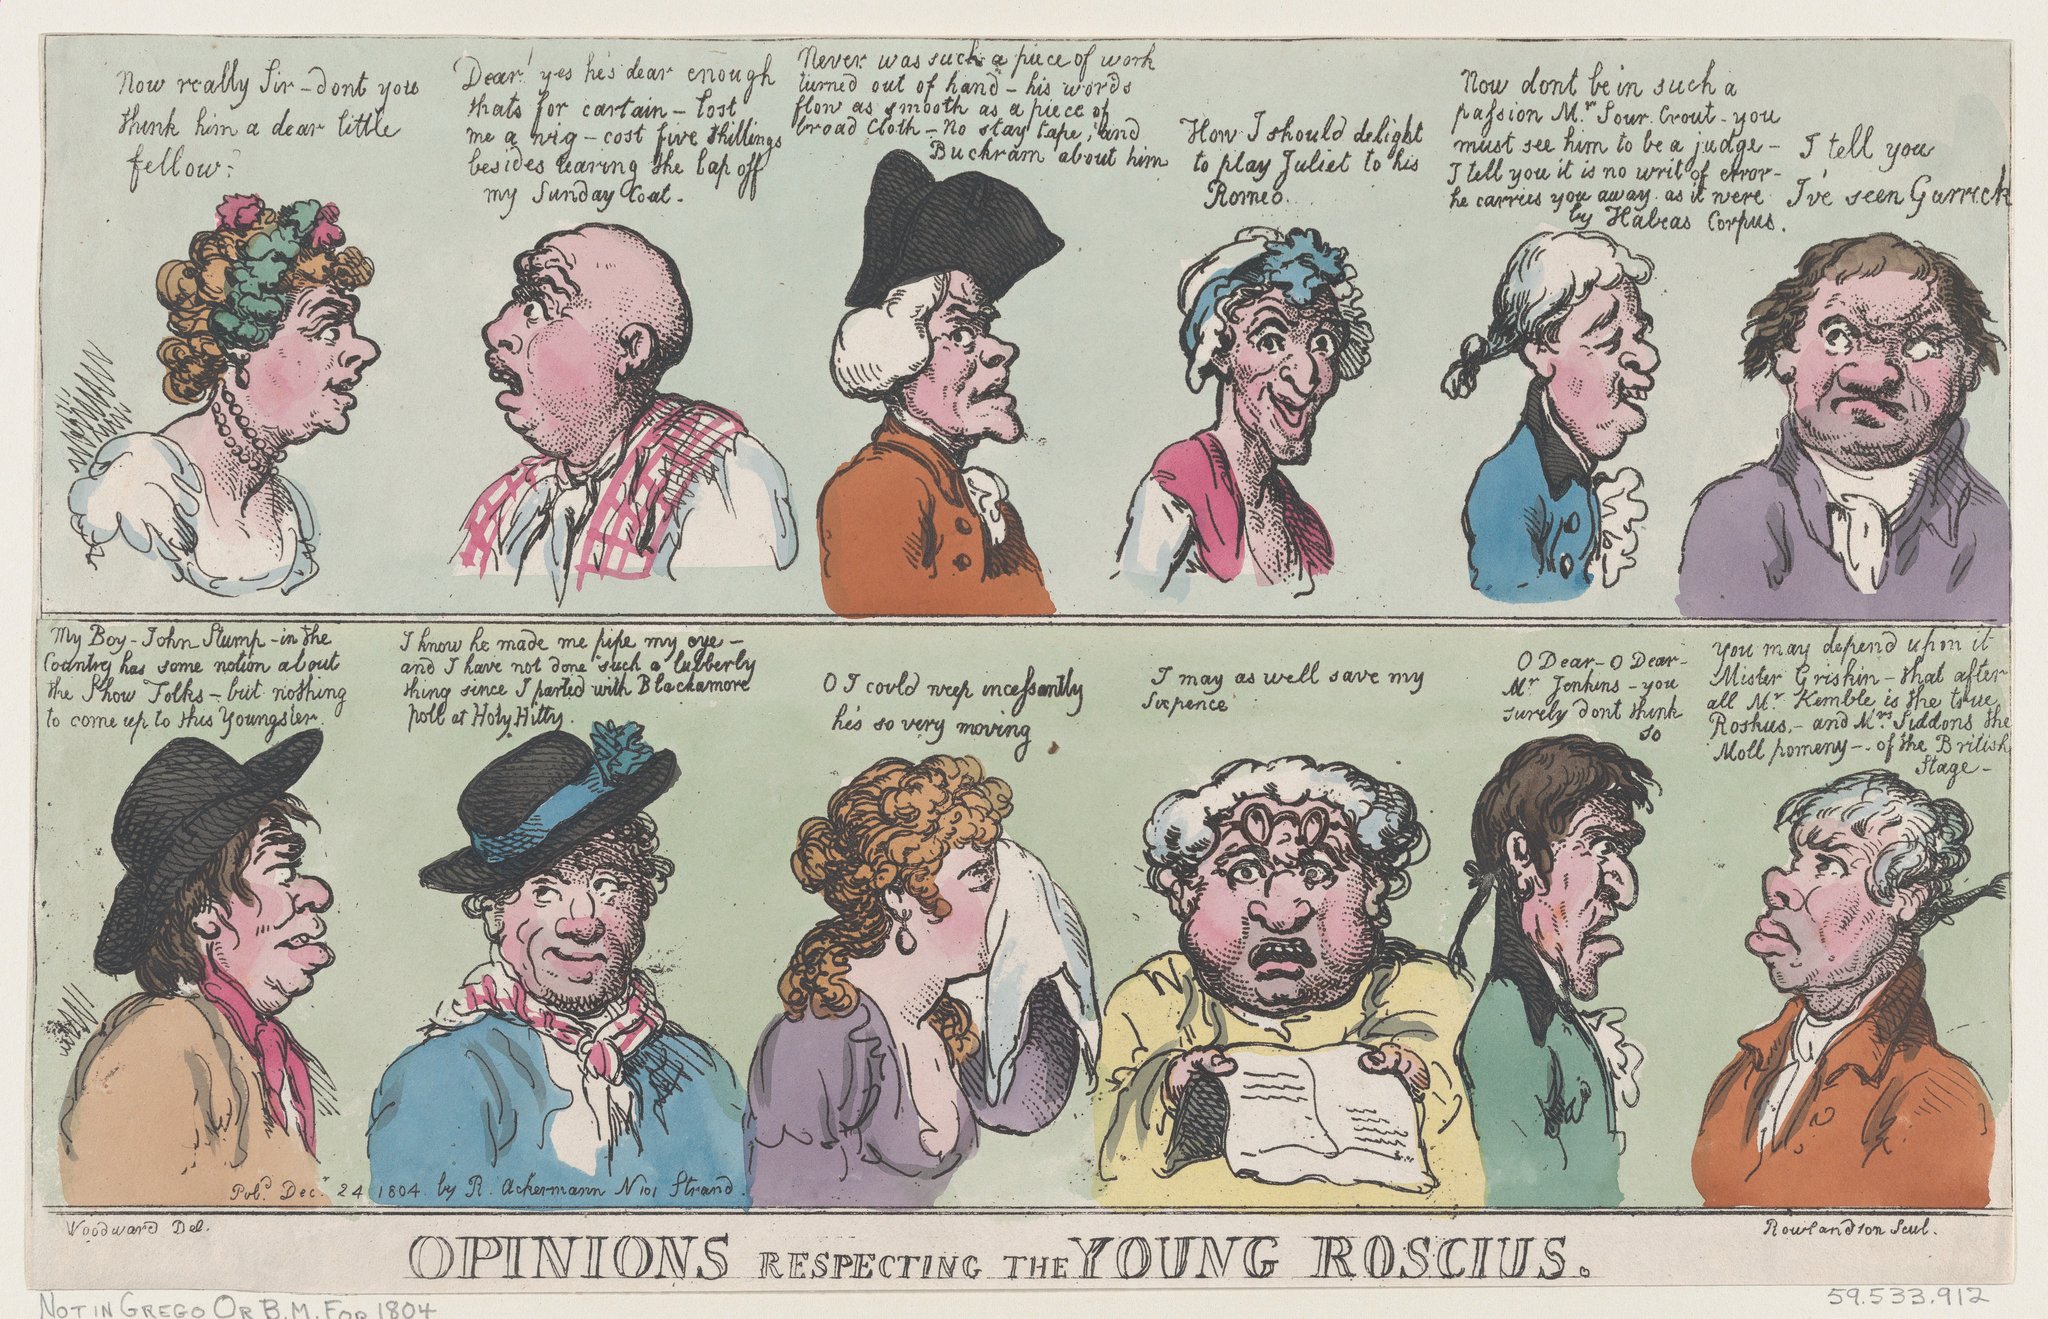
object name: print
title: Opinions Respecting The Young Roscius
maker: thomas rowlandson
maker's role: artist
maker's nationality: british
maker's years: 1757-1827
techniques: etching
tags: satire,men,women